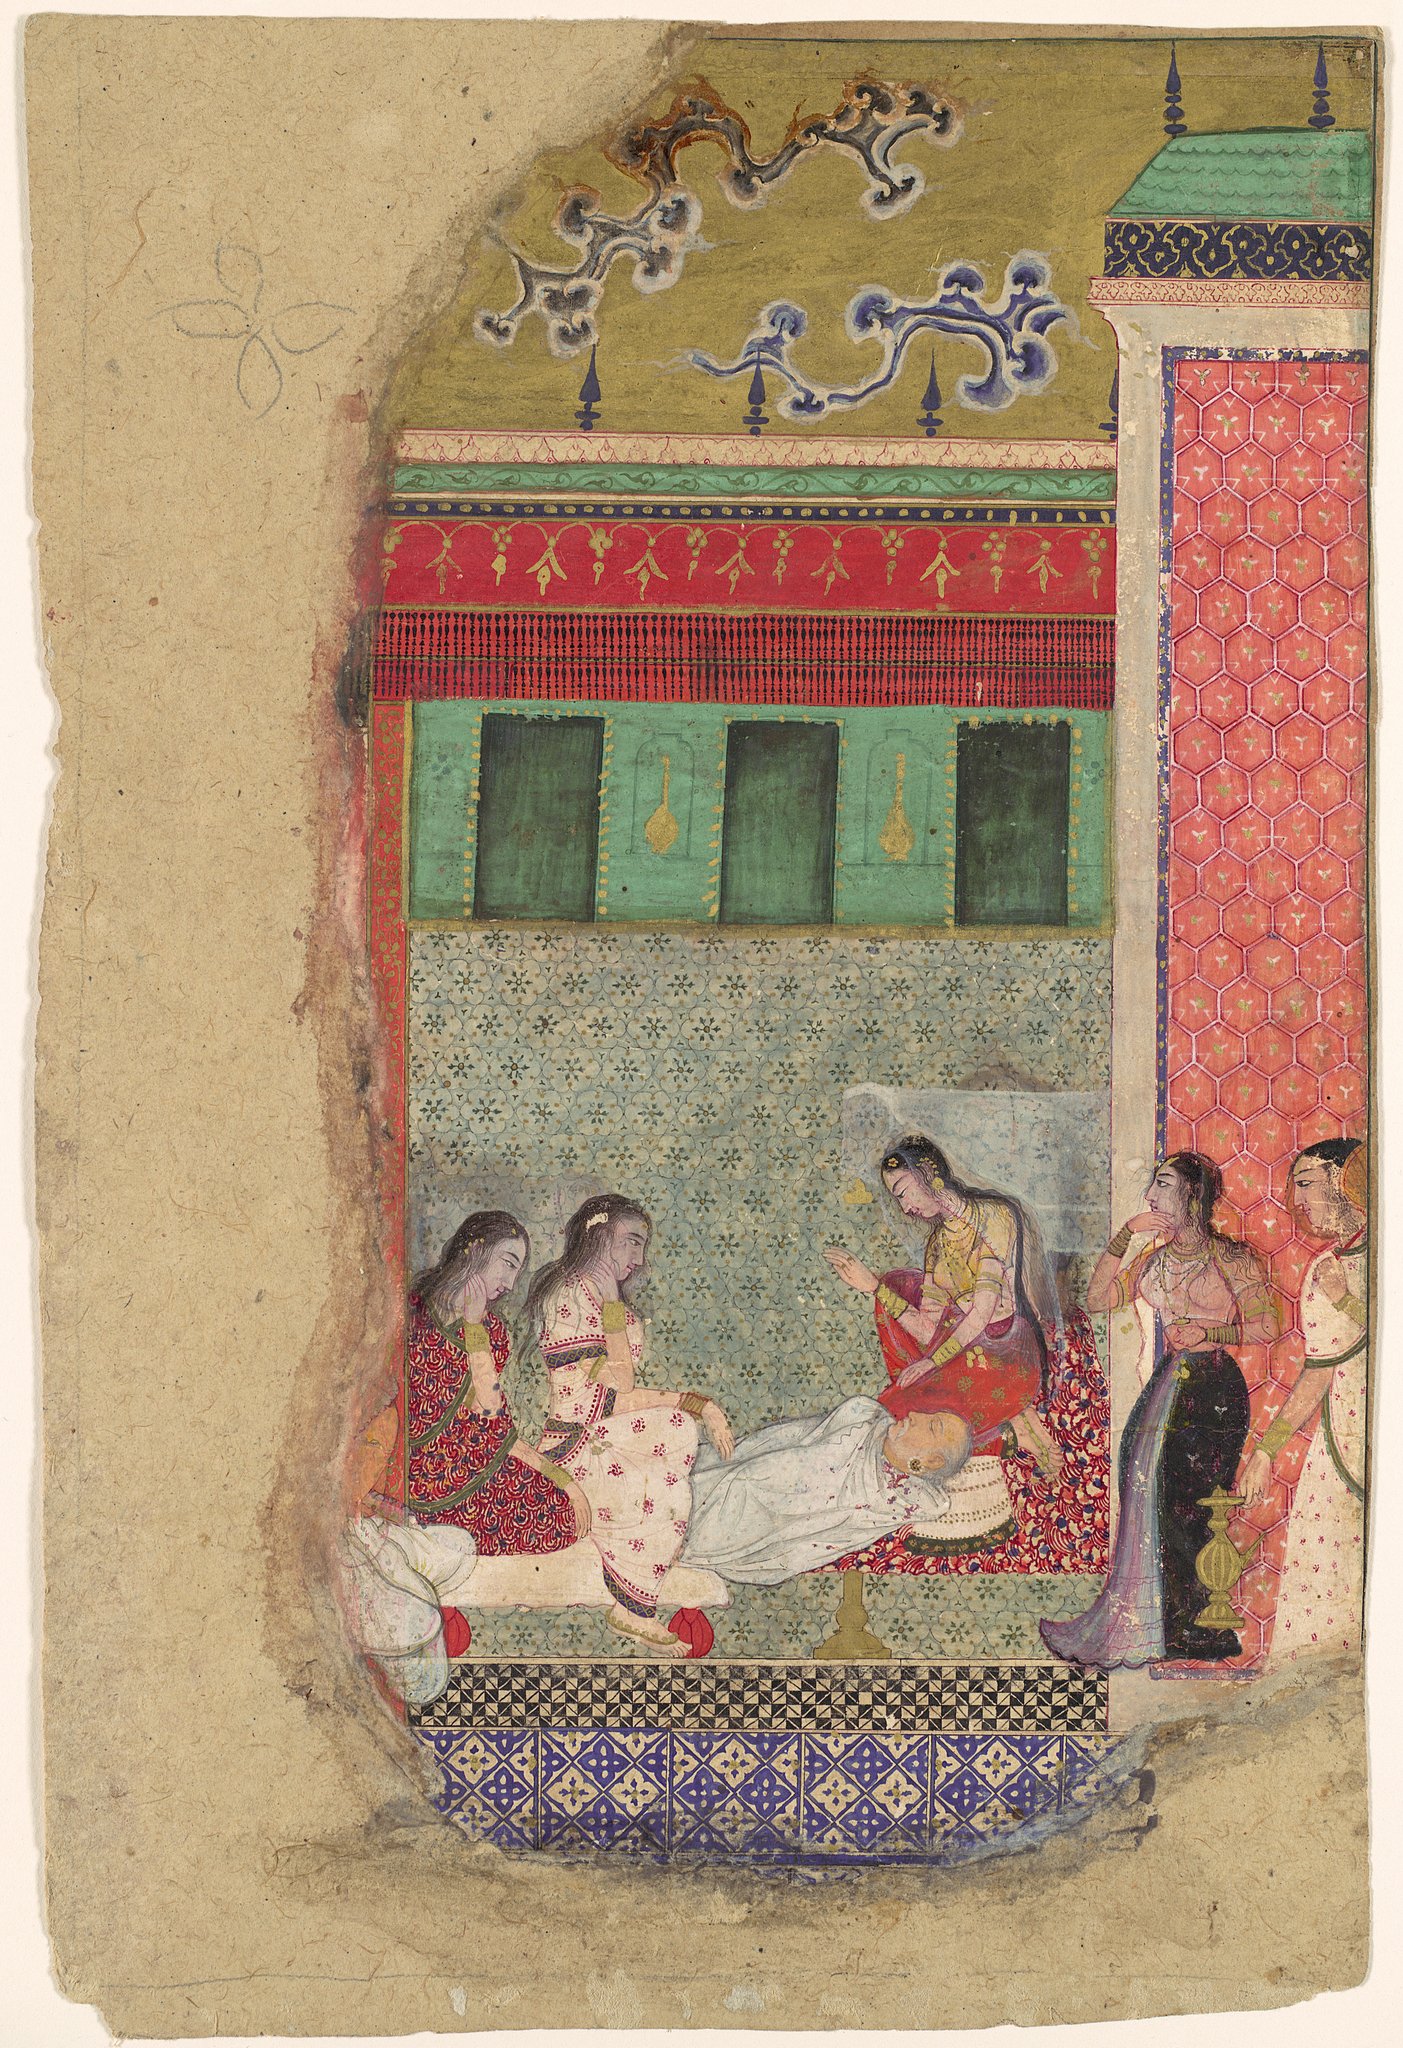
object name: folio from an illustrated manuscript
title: "The Death of King Dasharatha, the Father of Rama", Folio from a Ramayana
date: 1605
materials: gold, paper, watercolor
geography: india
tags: men,women,death